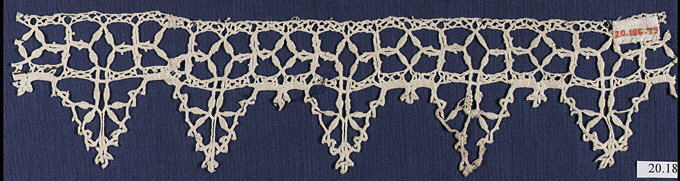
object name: edging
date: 1501-1600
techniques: lace